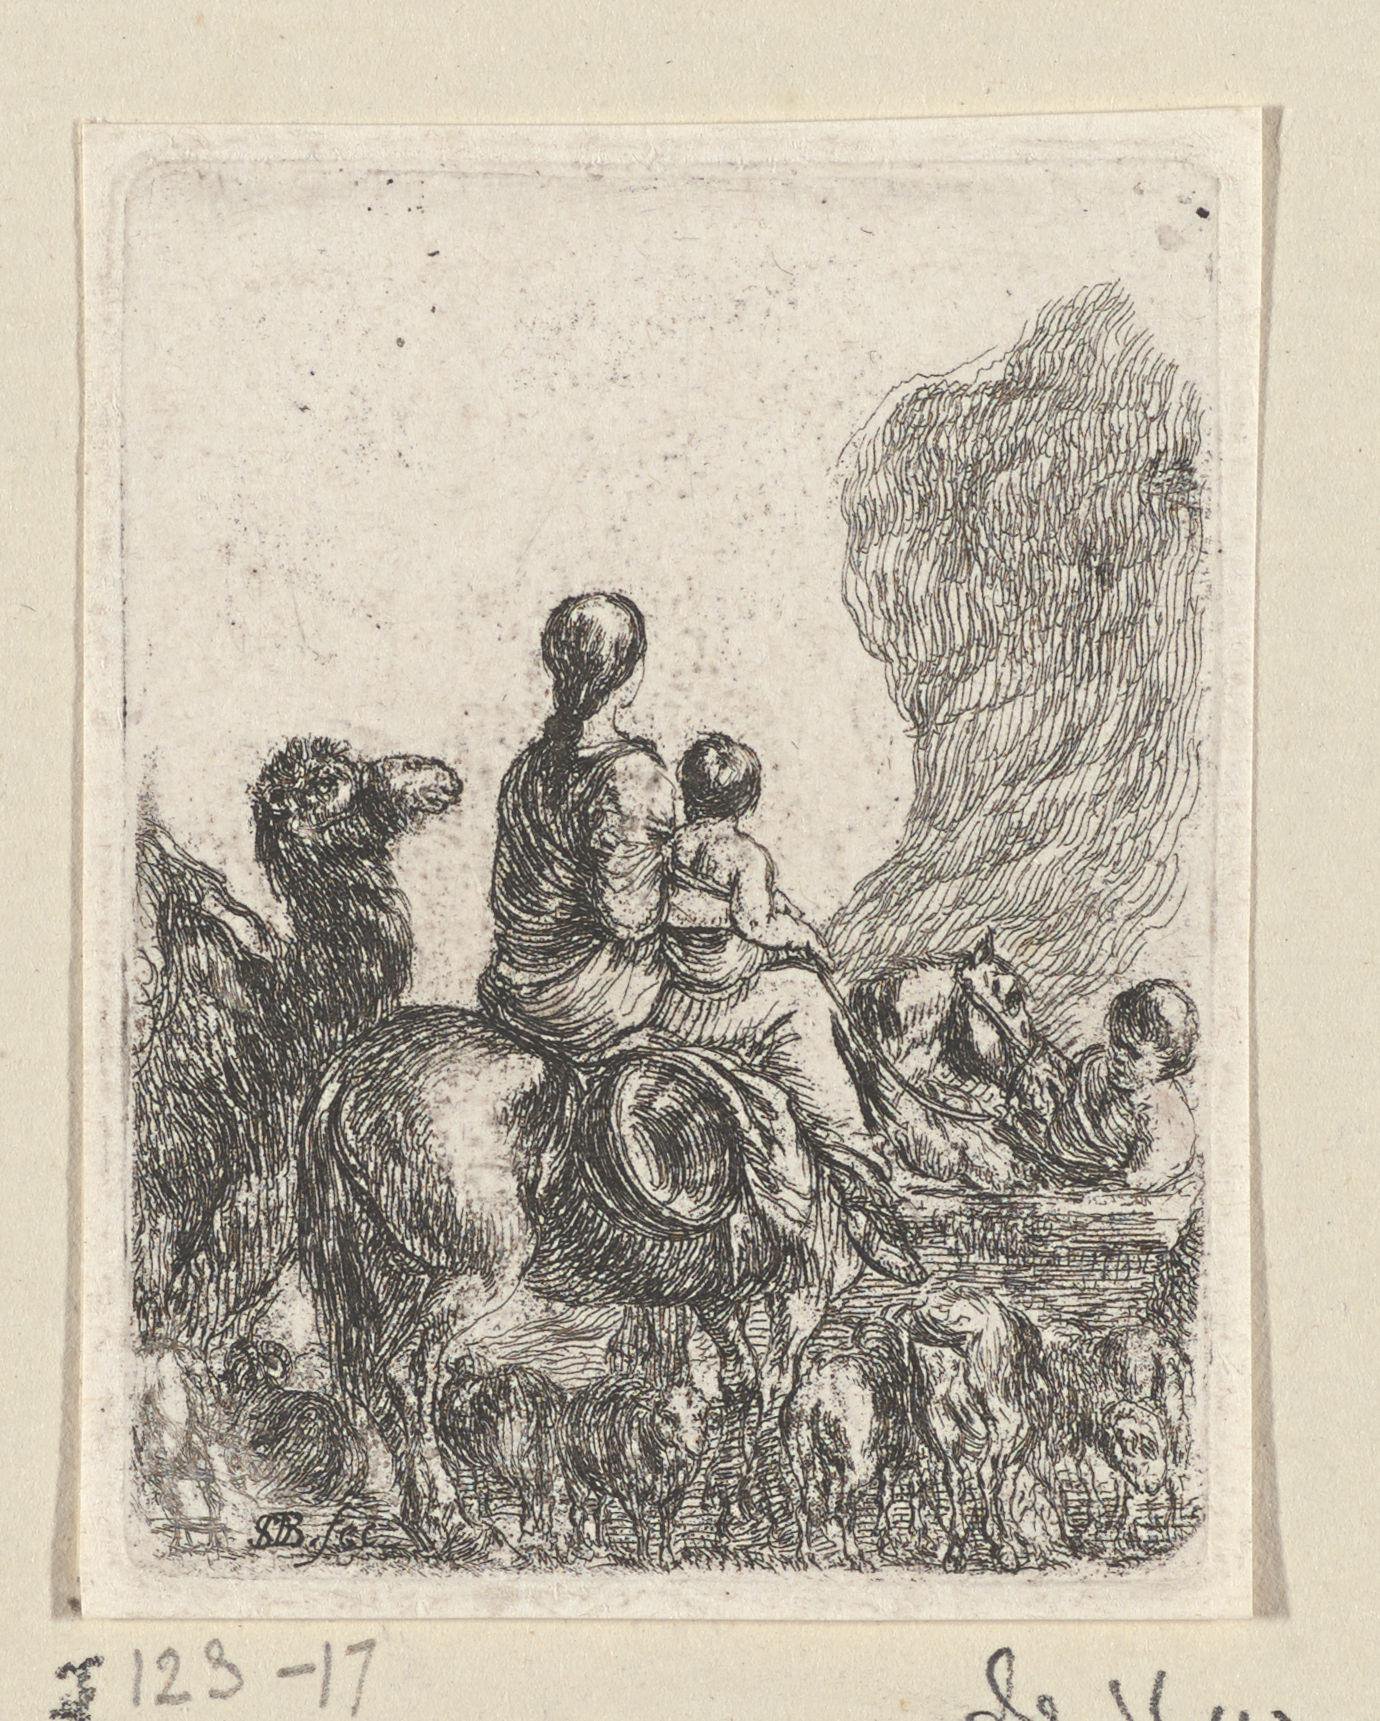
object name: print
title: Diverse figuren en krabbels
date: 1620-1664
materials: paper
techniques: etching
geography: paris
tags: riding a horse, ass, or mule; rider, horseman, hoofed animals: camel, sheep, mother and baby or young child, horse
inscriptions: collector's mark: Lugt 240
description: Vrouw en kind te paard, op de rug gezien. Achter het paard staat een kameel. Rondom het paard staan schapen. Rechts staat een jongen met een emmer met voer voor het paard.